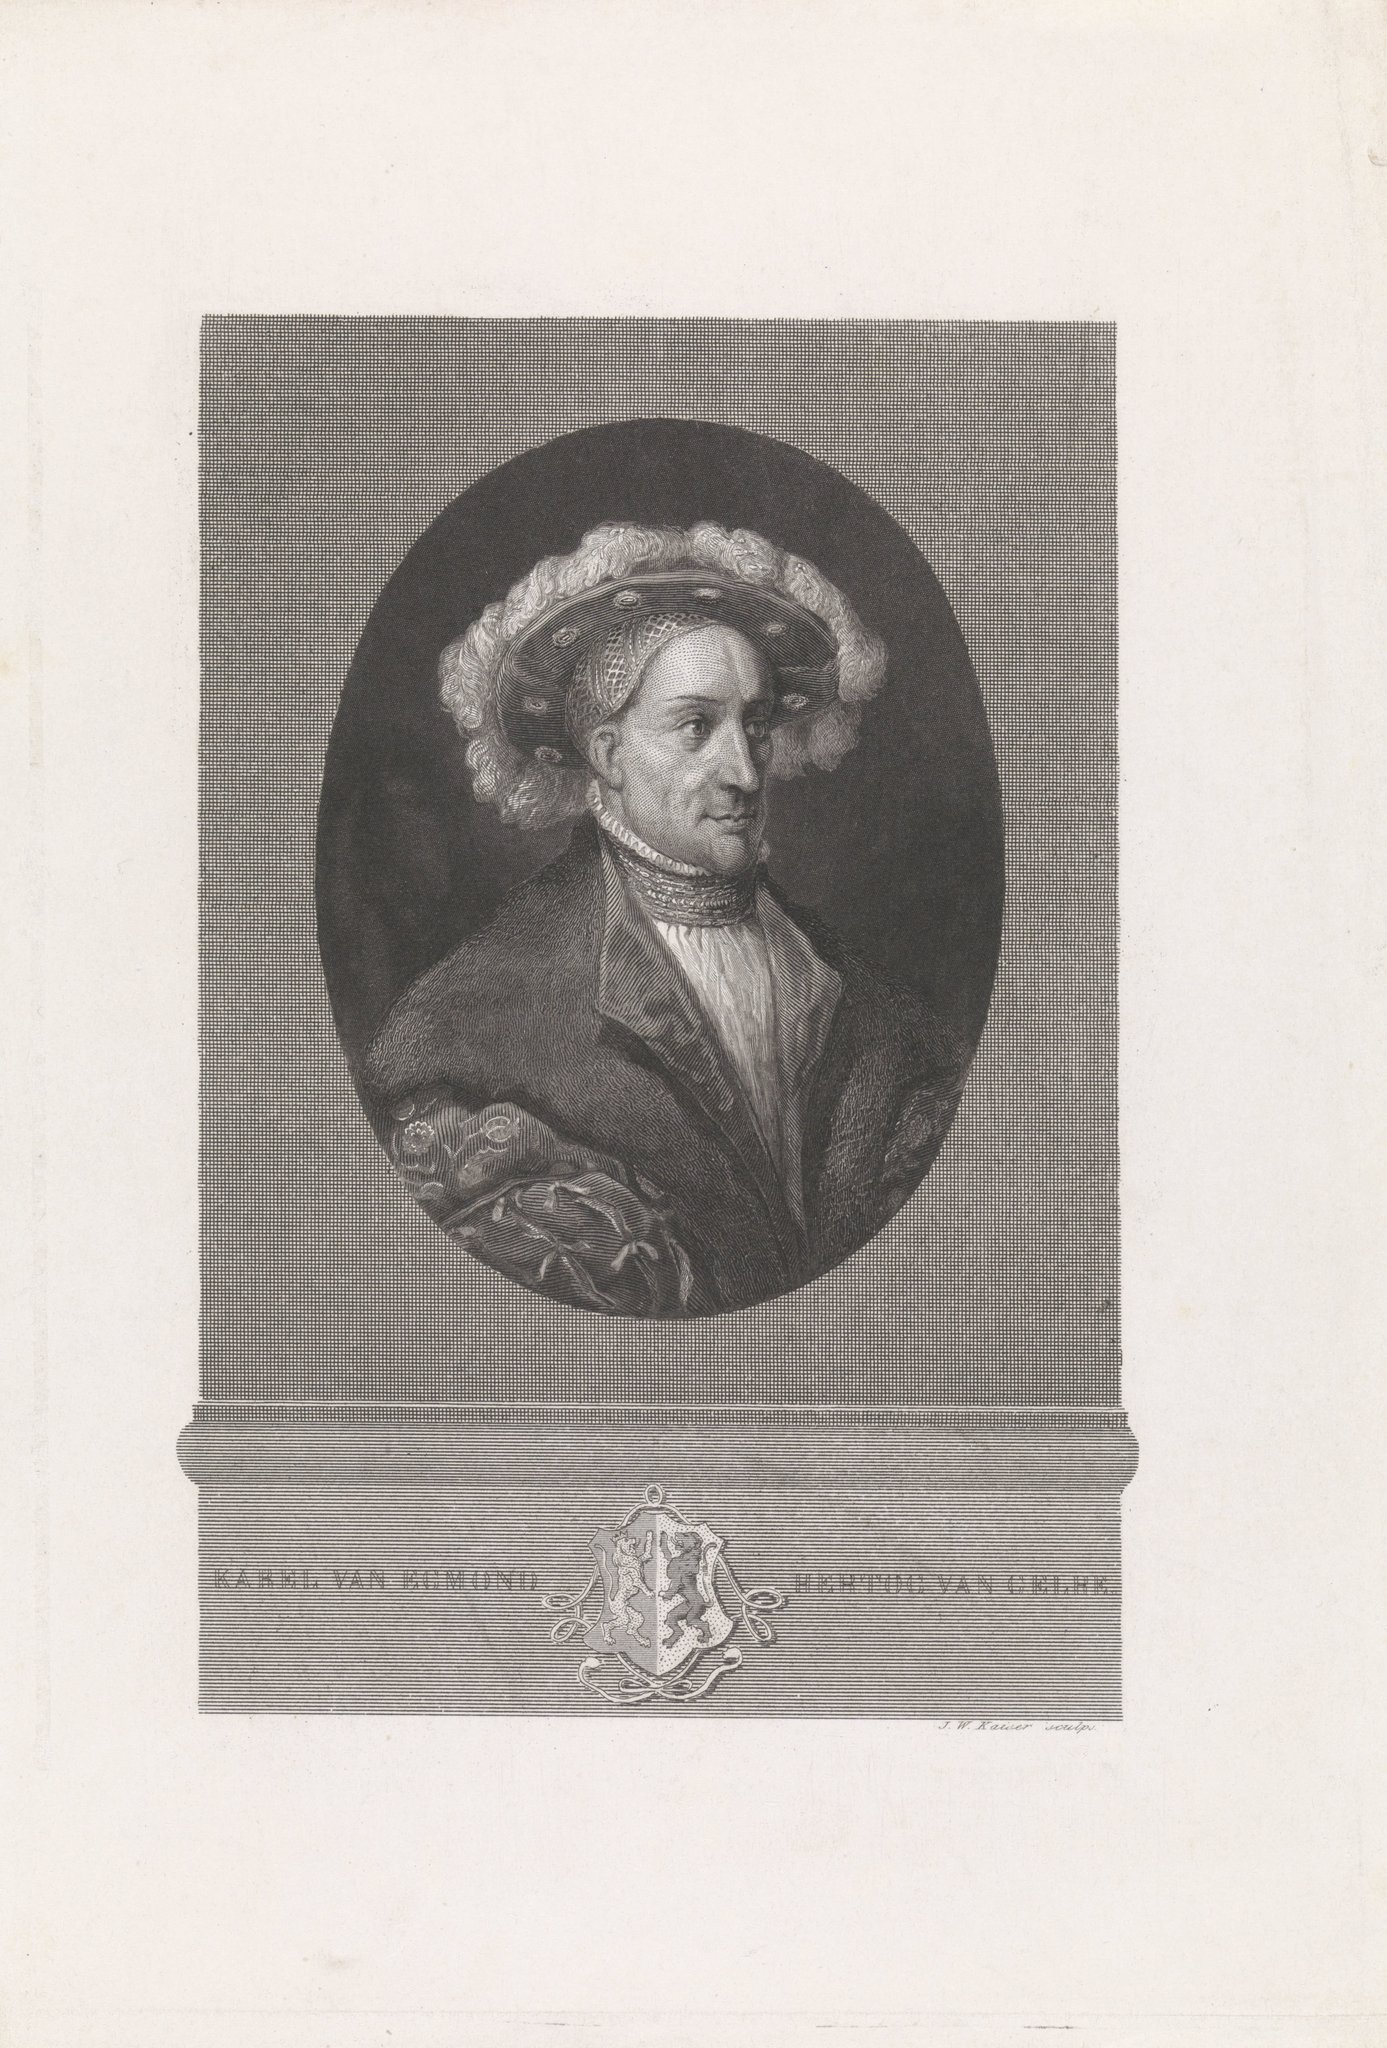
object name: print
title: Portret van Karel van Egmond, Hertog van Gelre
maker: johann wilhelm kaiser (i)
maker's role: draughtsman, print maker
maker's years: 1813-1900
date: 1840-1884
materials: paper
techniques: etching, roulette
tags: arnhem, earl, karel van egmond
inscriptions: collector's mark: Lugt 2228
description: Illustratie voor: Arend, Johannes Pieter. Algemeene geschiedenis des vaderlands van de vroegste tijden tot op heden. 5 delen, Amsterdam: Schleijer, J.F. 1840-1884, dl 2.3, p. 662.